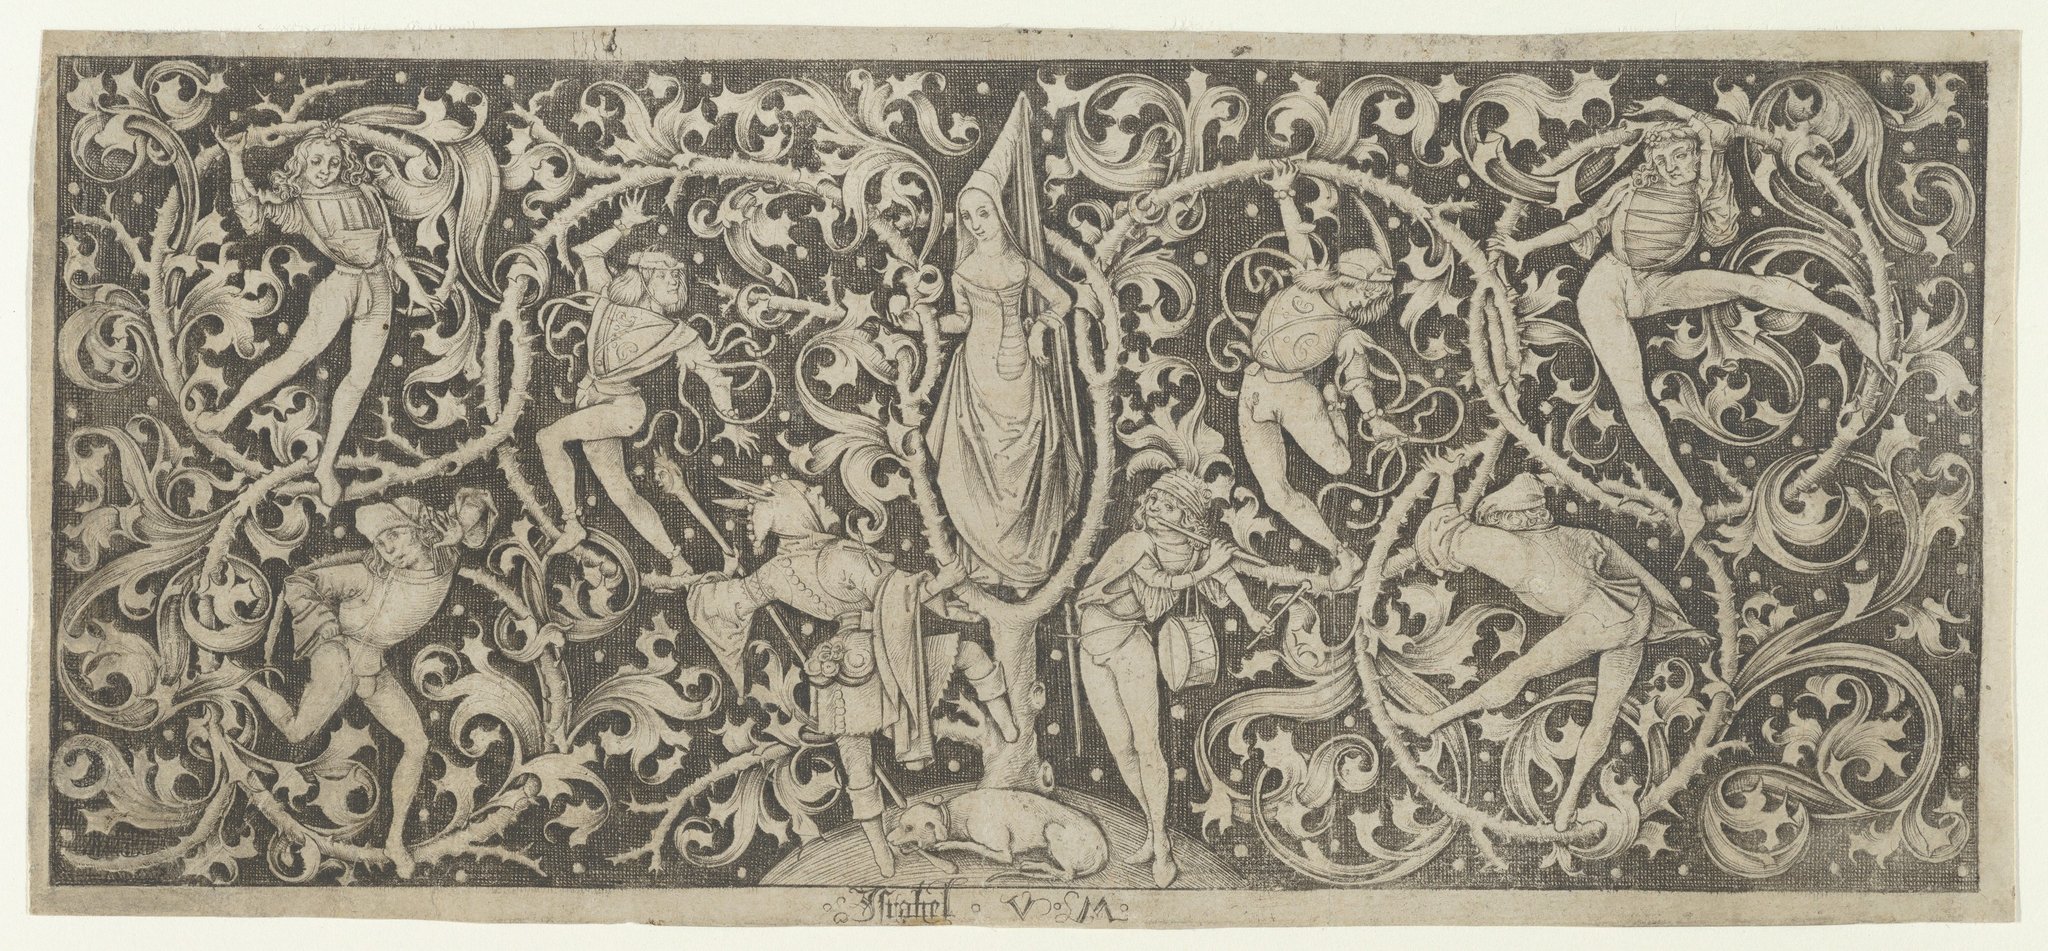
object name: print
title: Ornamental Engraving with Morris Dancers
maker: israhel van meckenem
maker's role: artist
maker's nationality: german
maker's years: 1435-1503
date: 1450-1503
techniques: engraving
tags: women,dancing,dancers